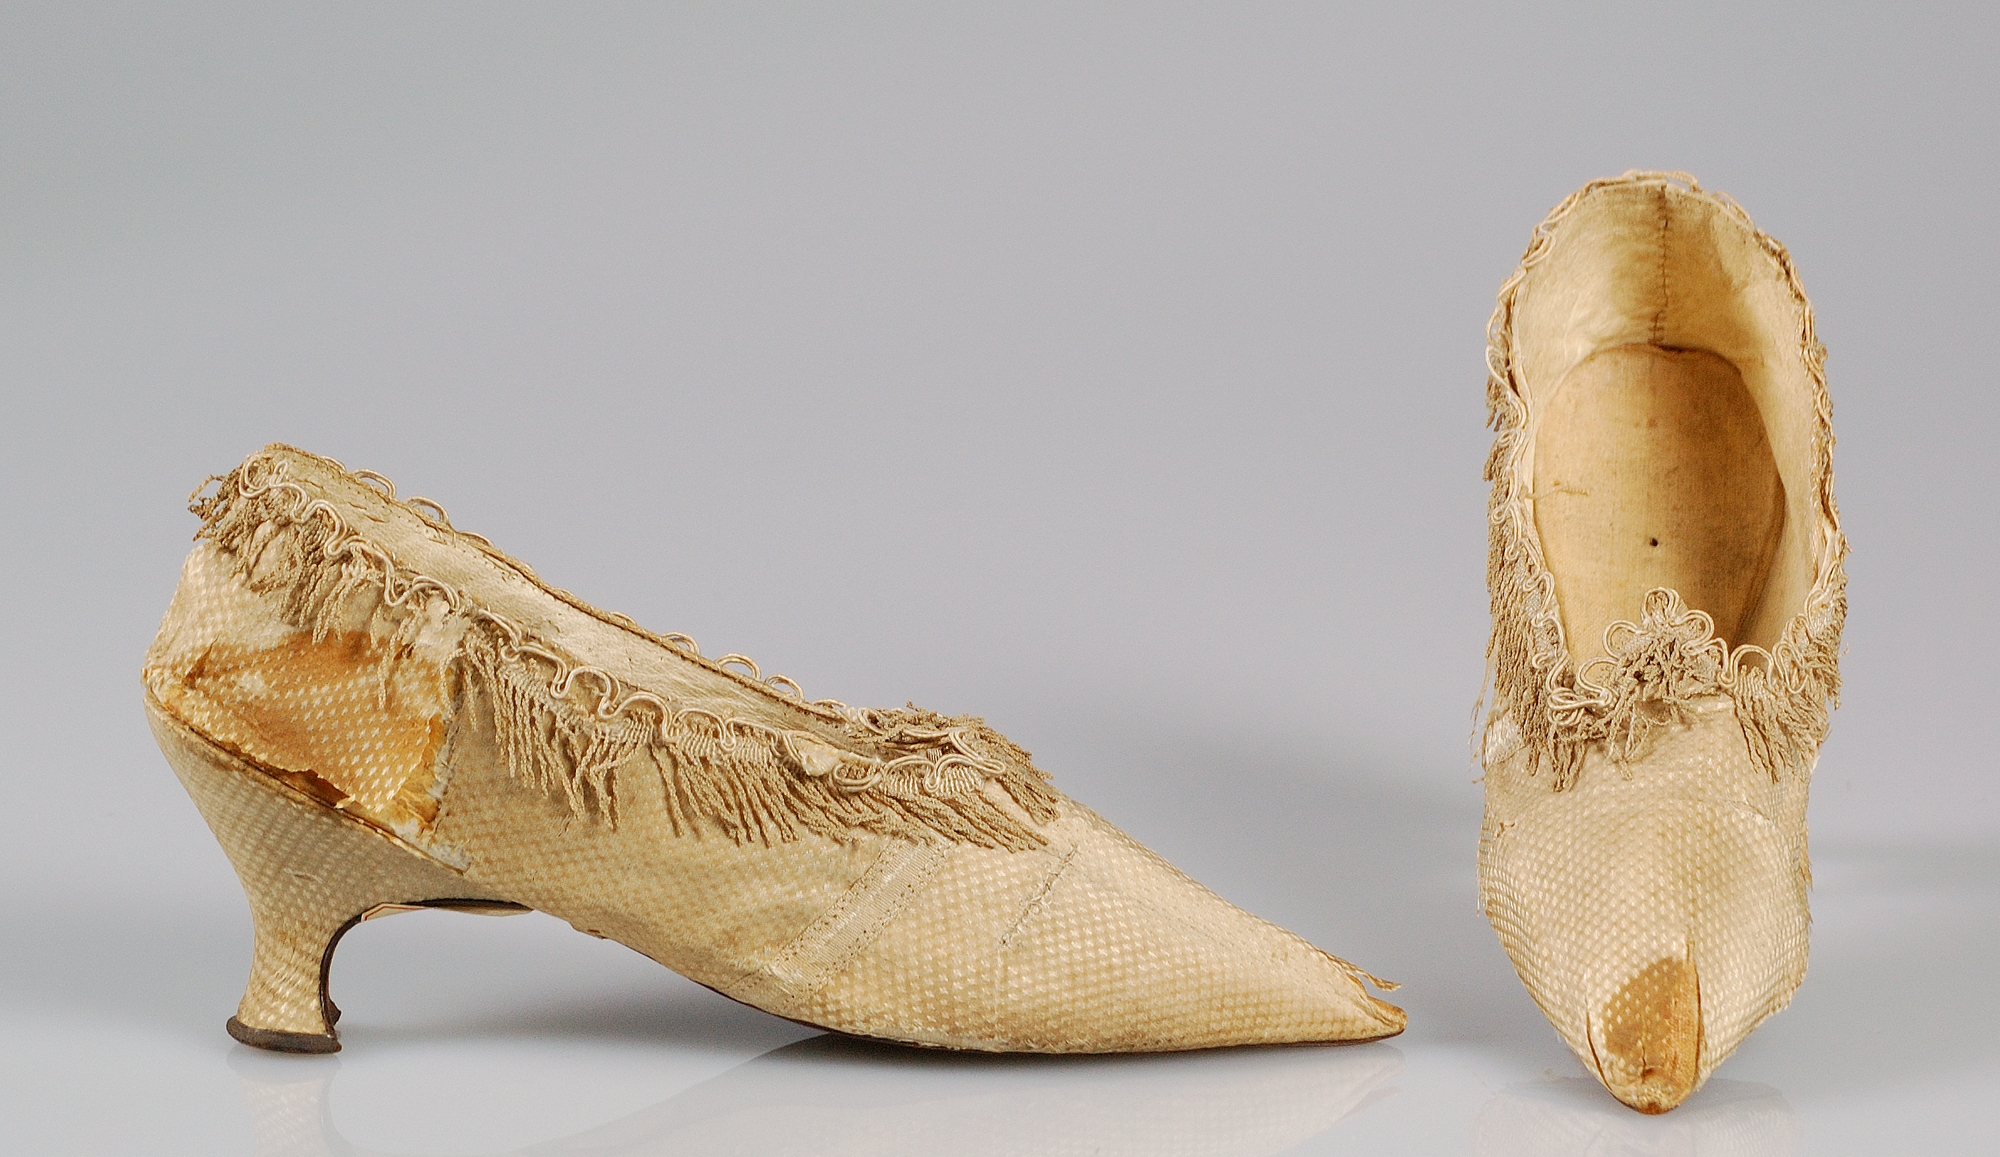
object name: slipper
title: Slippers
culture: french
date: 1790-1795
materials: silk